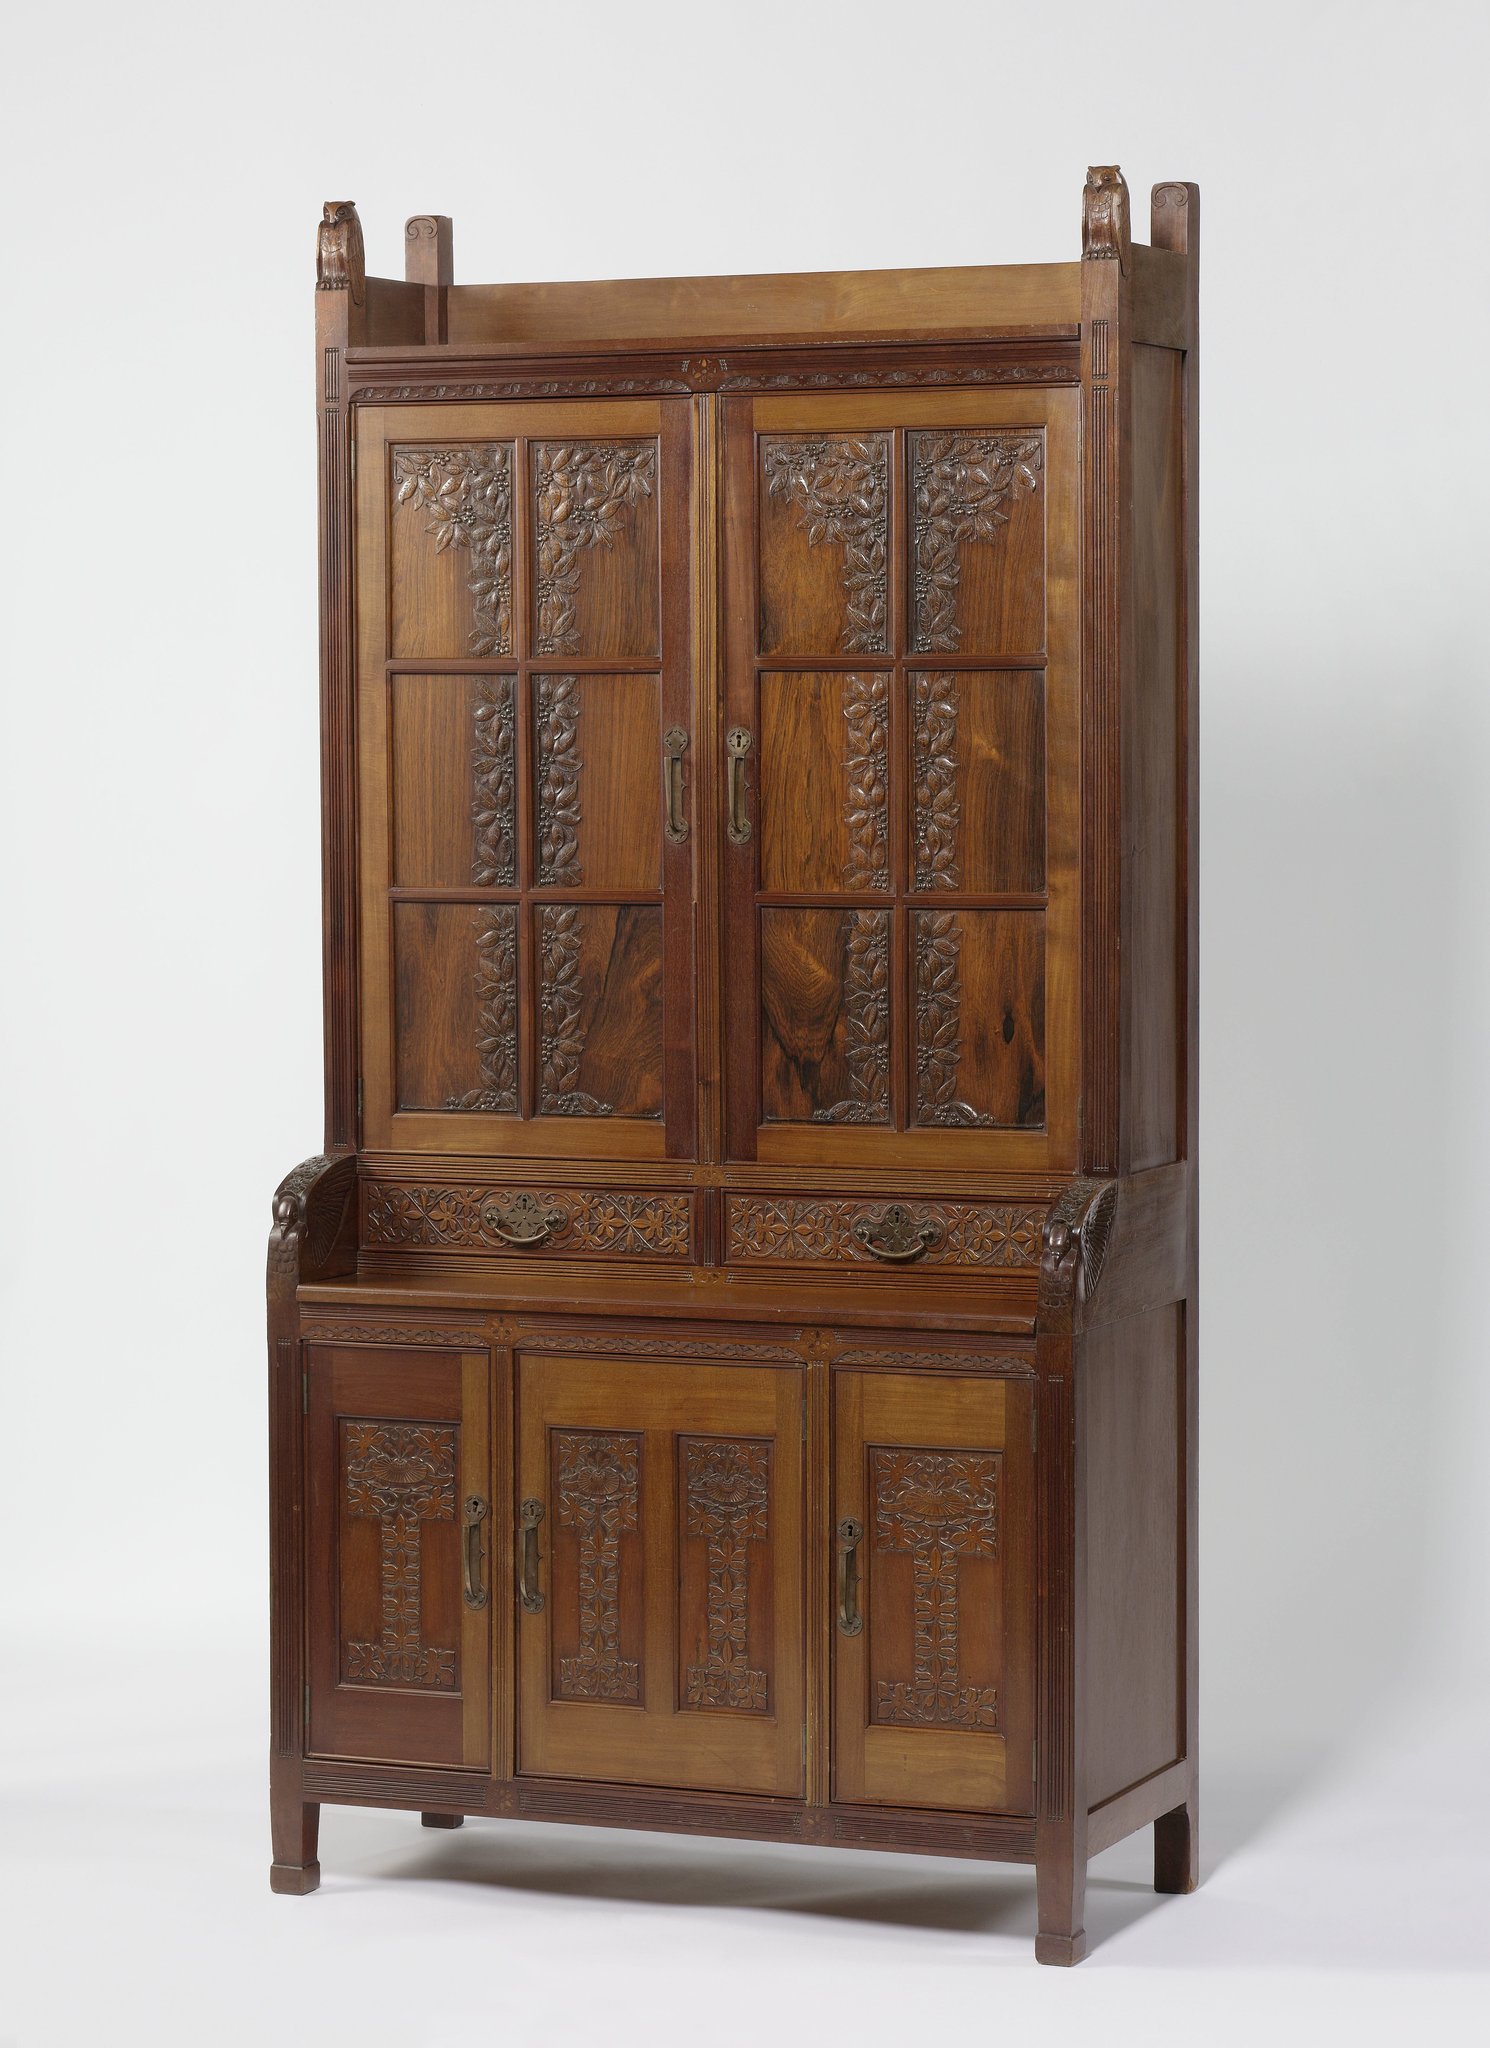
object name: furniture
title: Meubilair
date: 1905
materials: copper, wood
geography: amsterdam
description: Kast van eike-, mahonie- en palissanderhout met koperbeslag. De onderkast heeft een brede middendeur met twee panelen en twee smallere zijdeuren. De terugspringende hoge bovenkast heeft twee deuren met roedeverdeling boven twee laden. De deuren tonen florale motieven in boomvorm, de laden bladwerk. Staafwerk op hoekstijlen en regels. De bovenste hoekstijlen eindigen van voren in een uil en van achteren in een voluut. Op de hoogte van de laden zijn de zijwanden versierd met duivekop- en vleugels en bloemen.